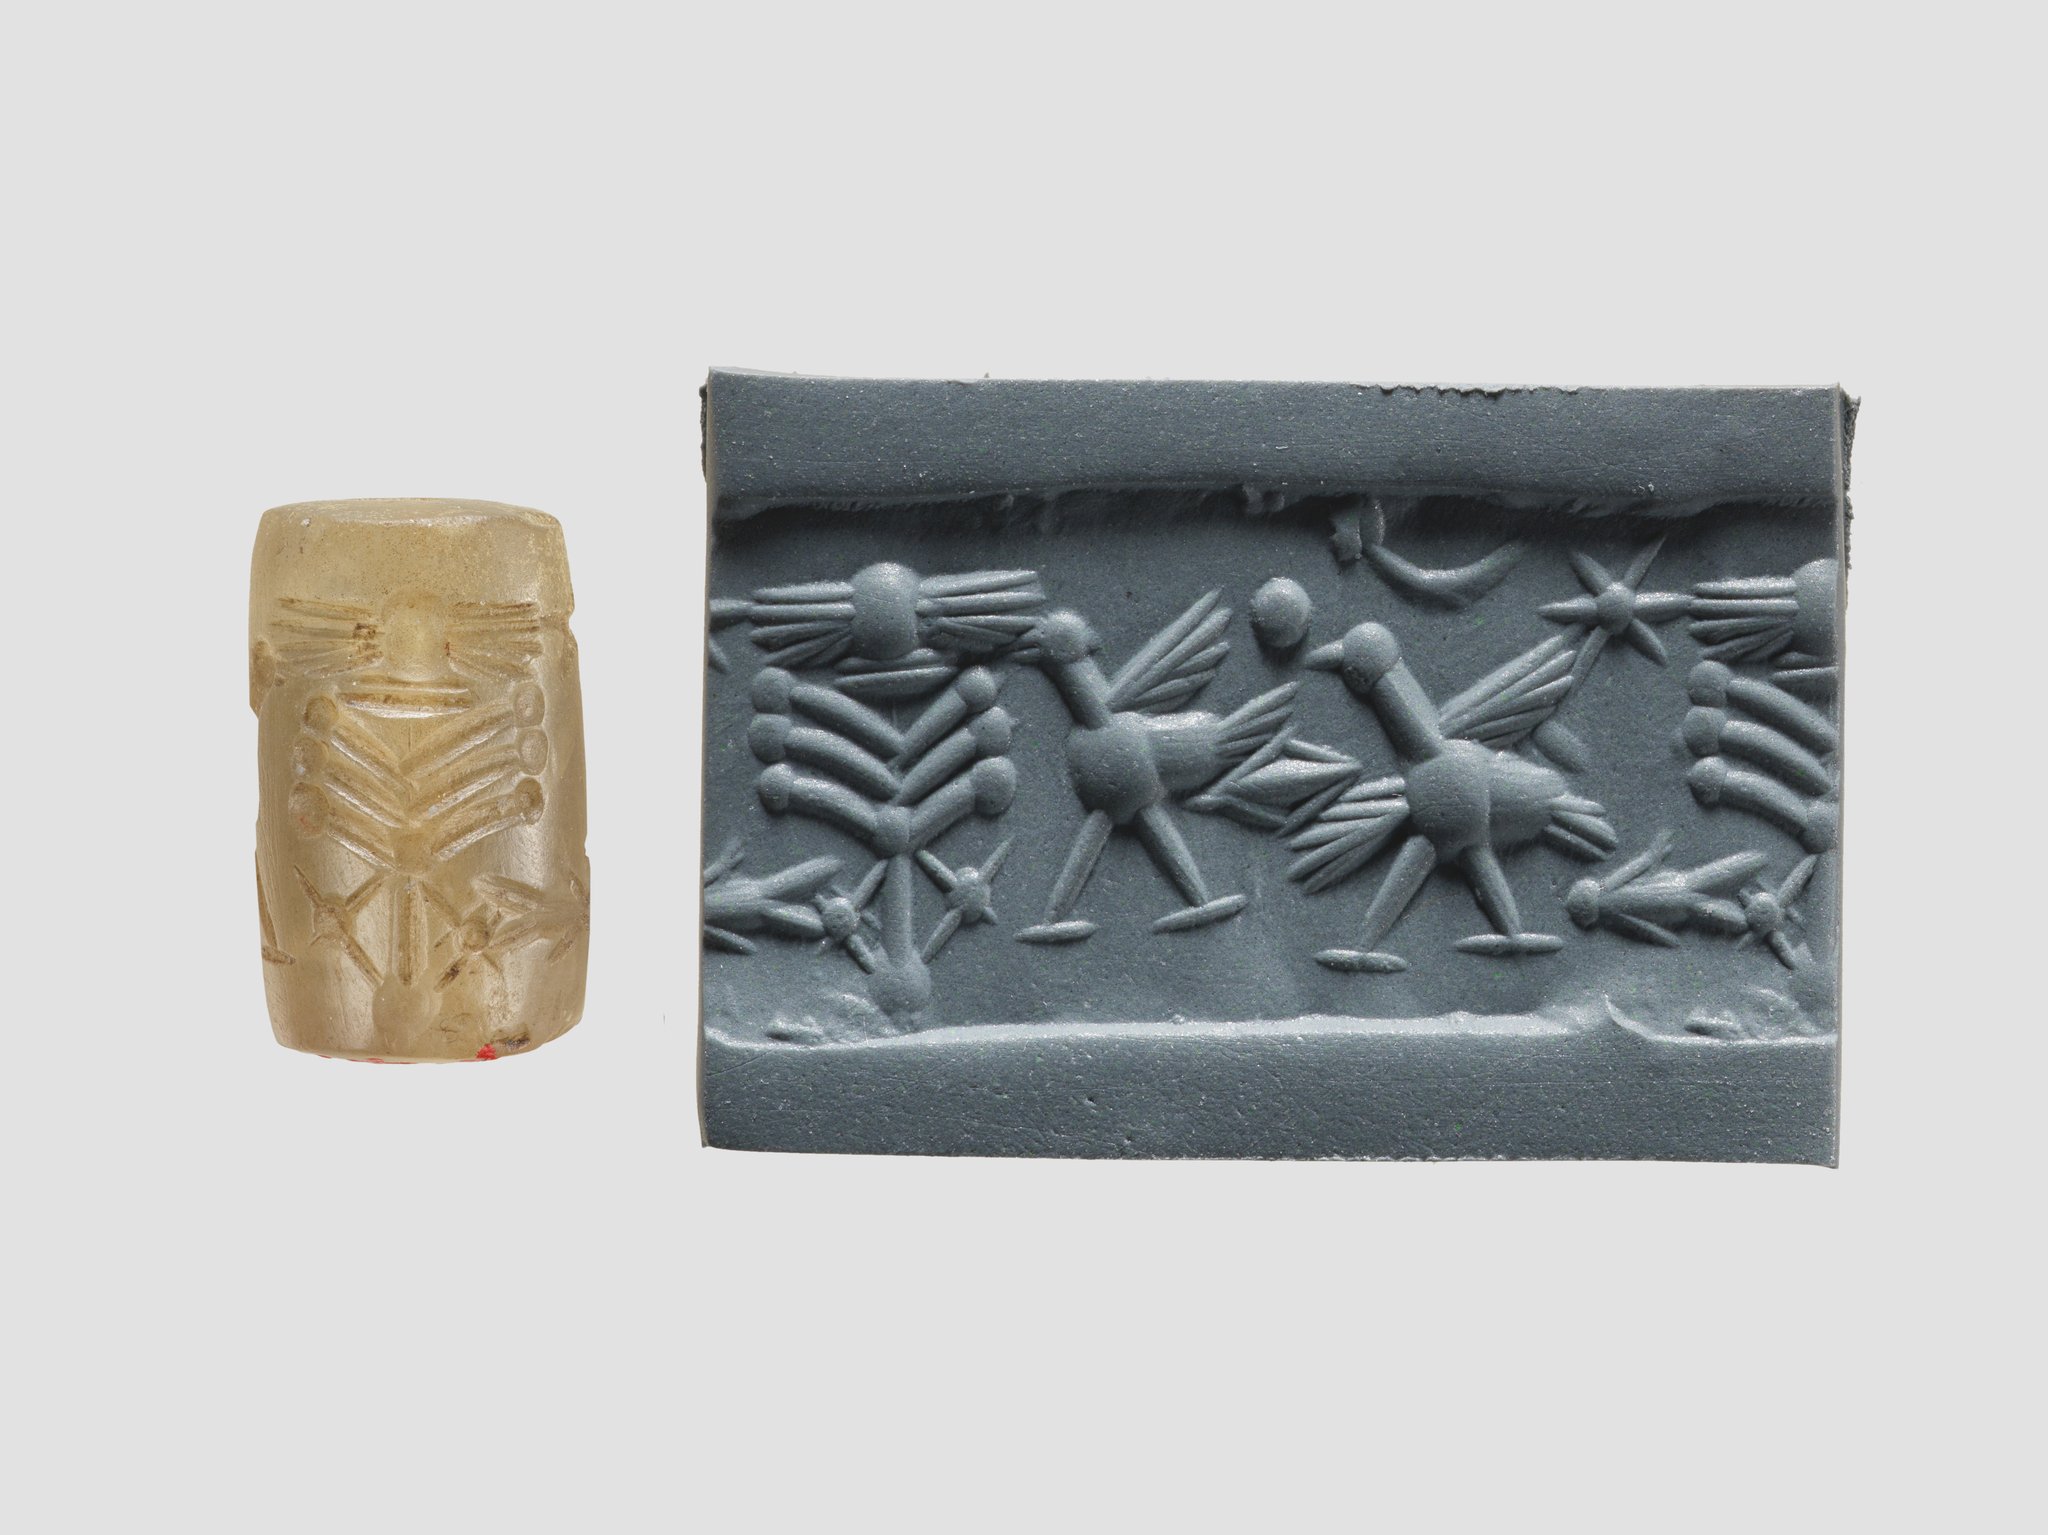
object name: cylinder seal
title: Cylinder seal with animals and divine symbols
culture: assyrian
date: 700-601 BCE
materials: stone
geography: mesopotamia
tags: birds